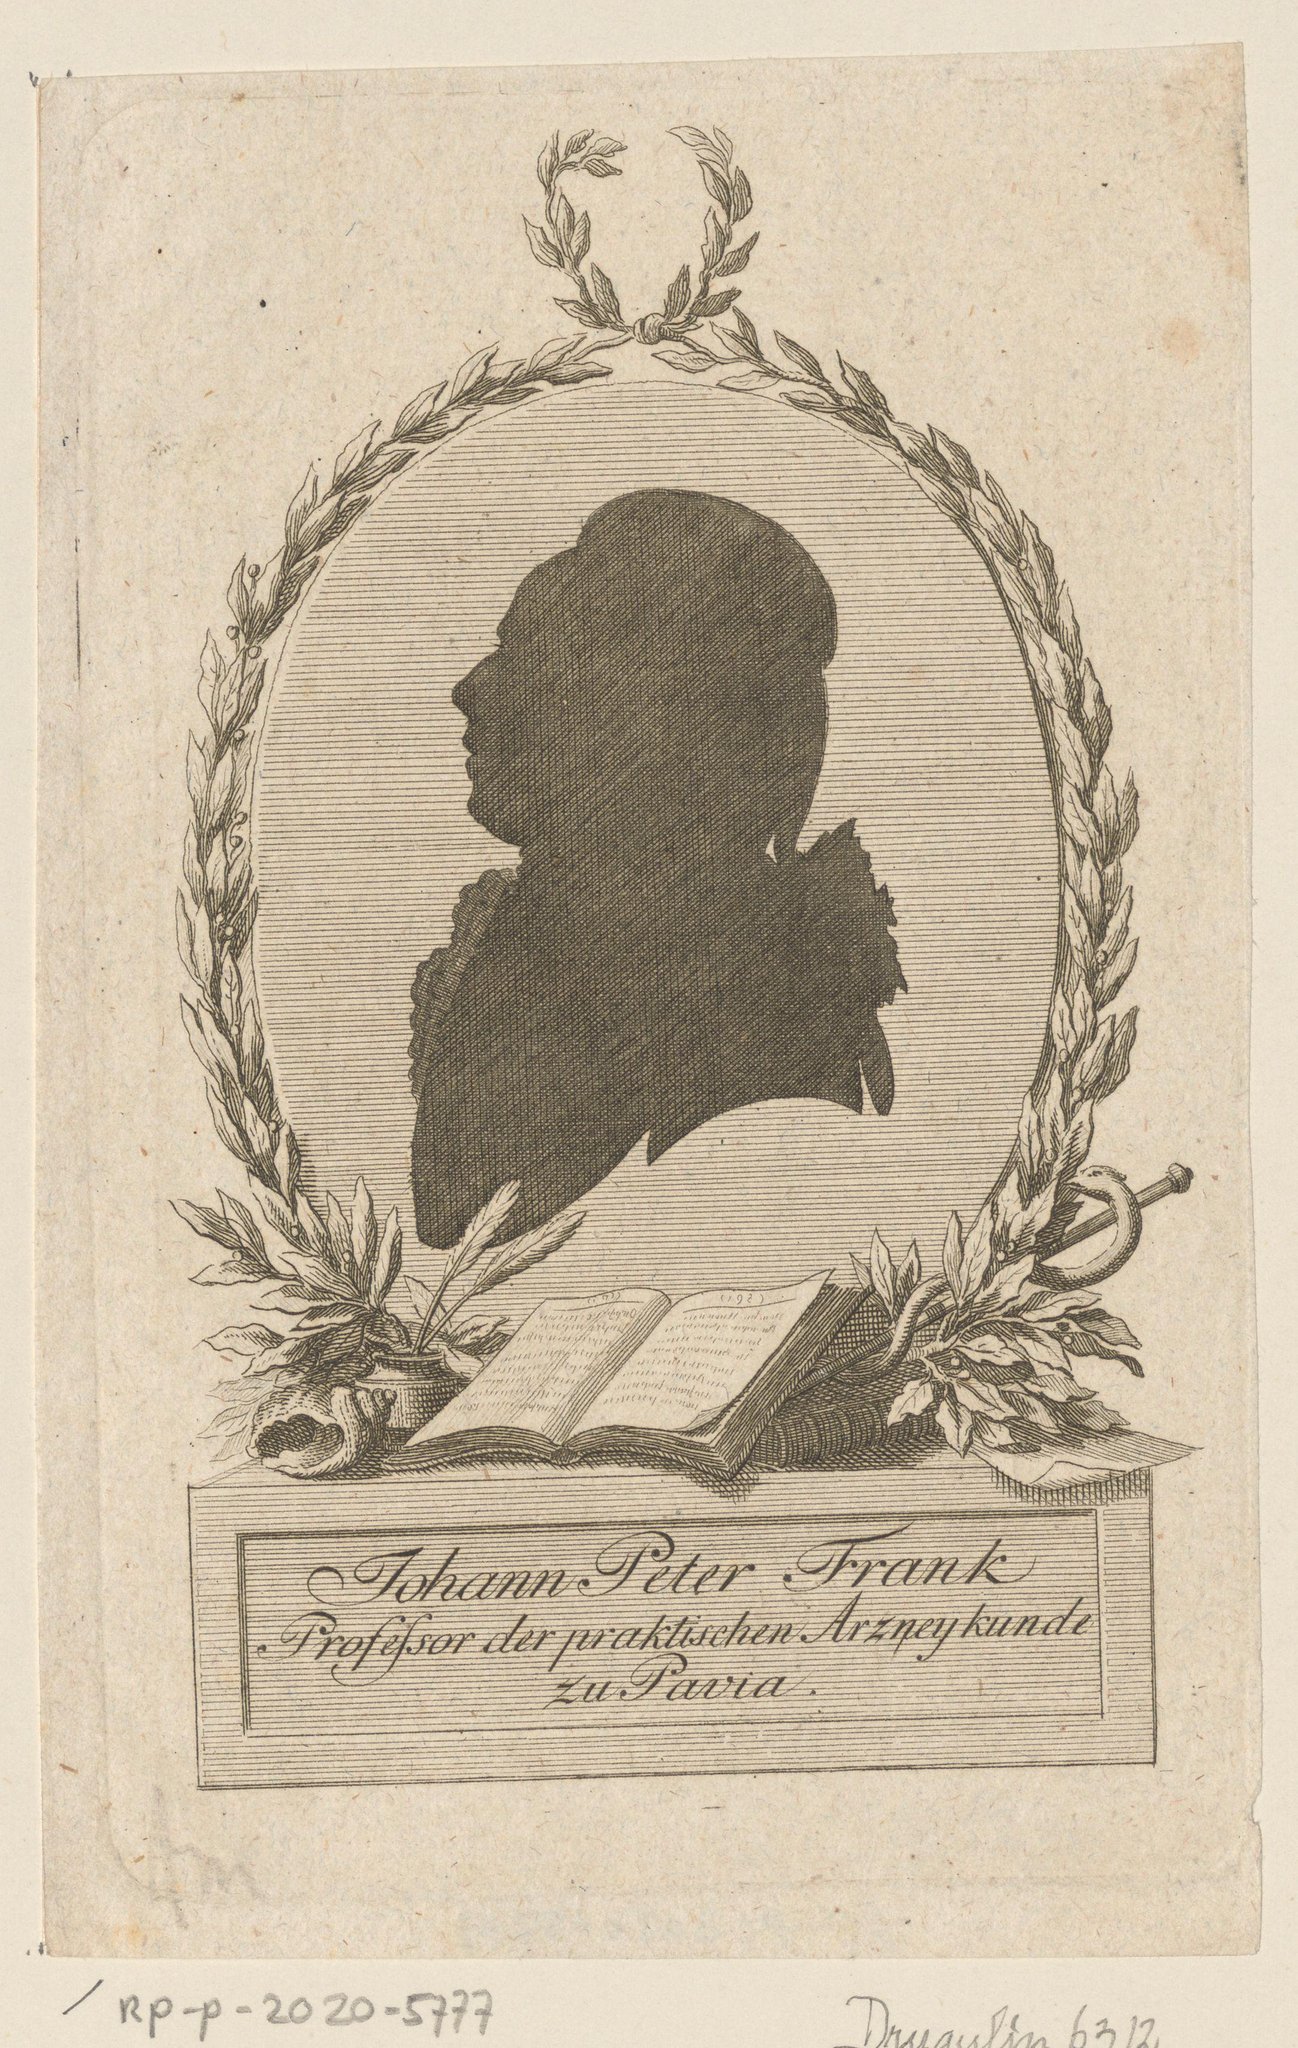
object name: print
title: Silhouetportret van Johann Peter Frank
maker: Anonymous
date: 1785-1820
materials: paper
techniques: etching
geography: germany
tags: vienna, historical persons, book - mm - book open, scallop, shell ~ ornament, aesculapian sign